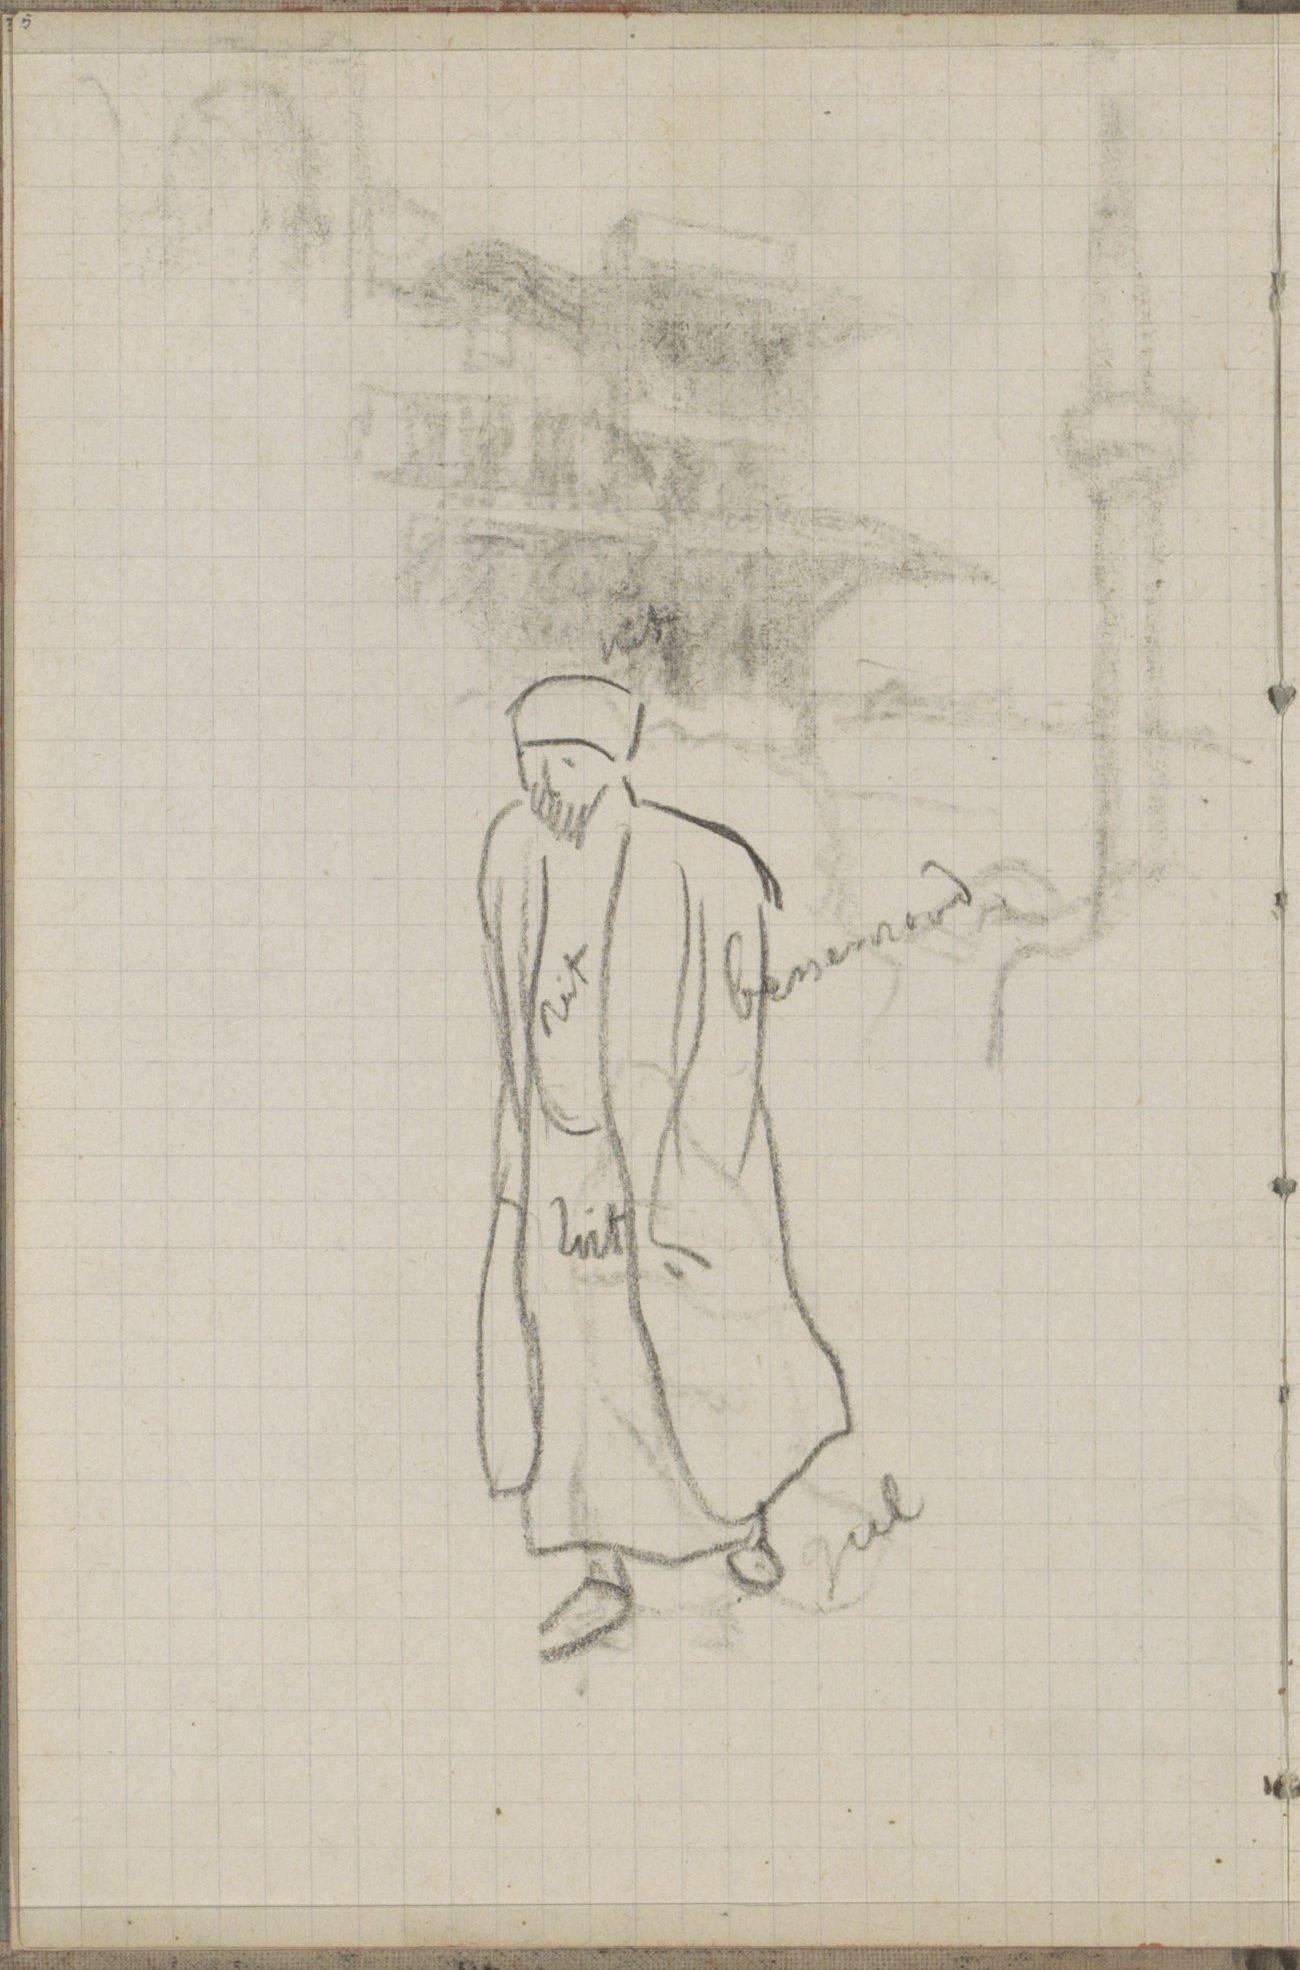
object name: sketchbook leaf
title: Lopende man in oosterse kleding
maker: marius bauer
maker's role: draughtsman, print maker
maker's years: 1867-1932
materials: chalk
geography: istanbul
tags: asiatic races and peoples, adult man, walking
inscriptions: kleurnotitie, handgeschreven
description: Met baard en van voren gezien. Pagina 5 uit een schetsboek met 54 bladen